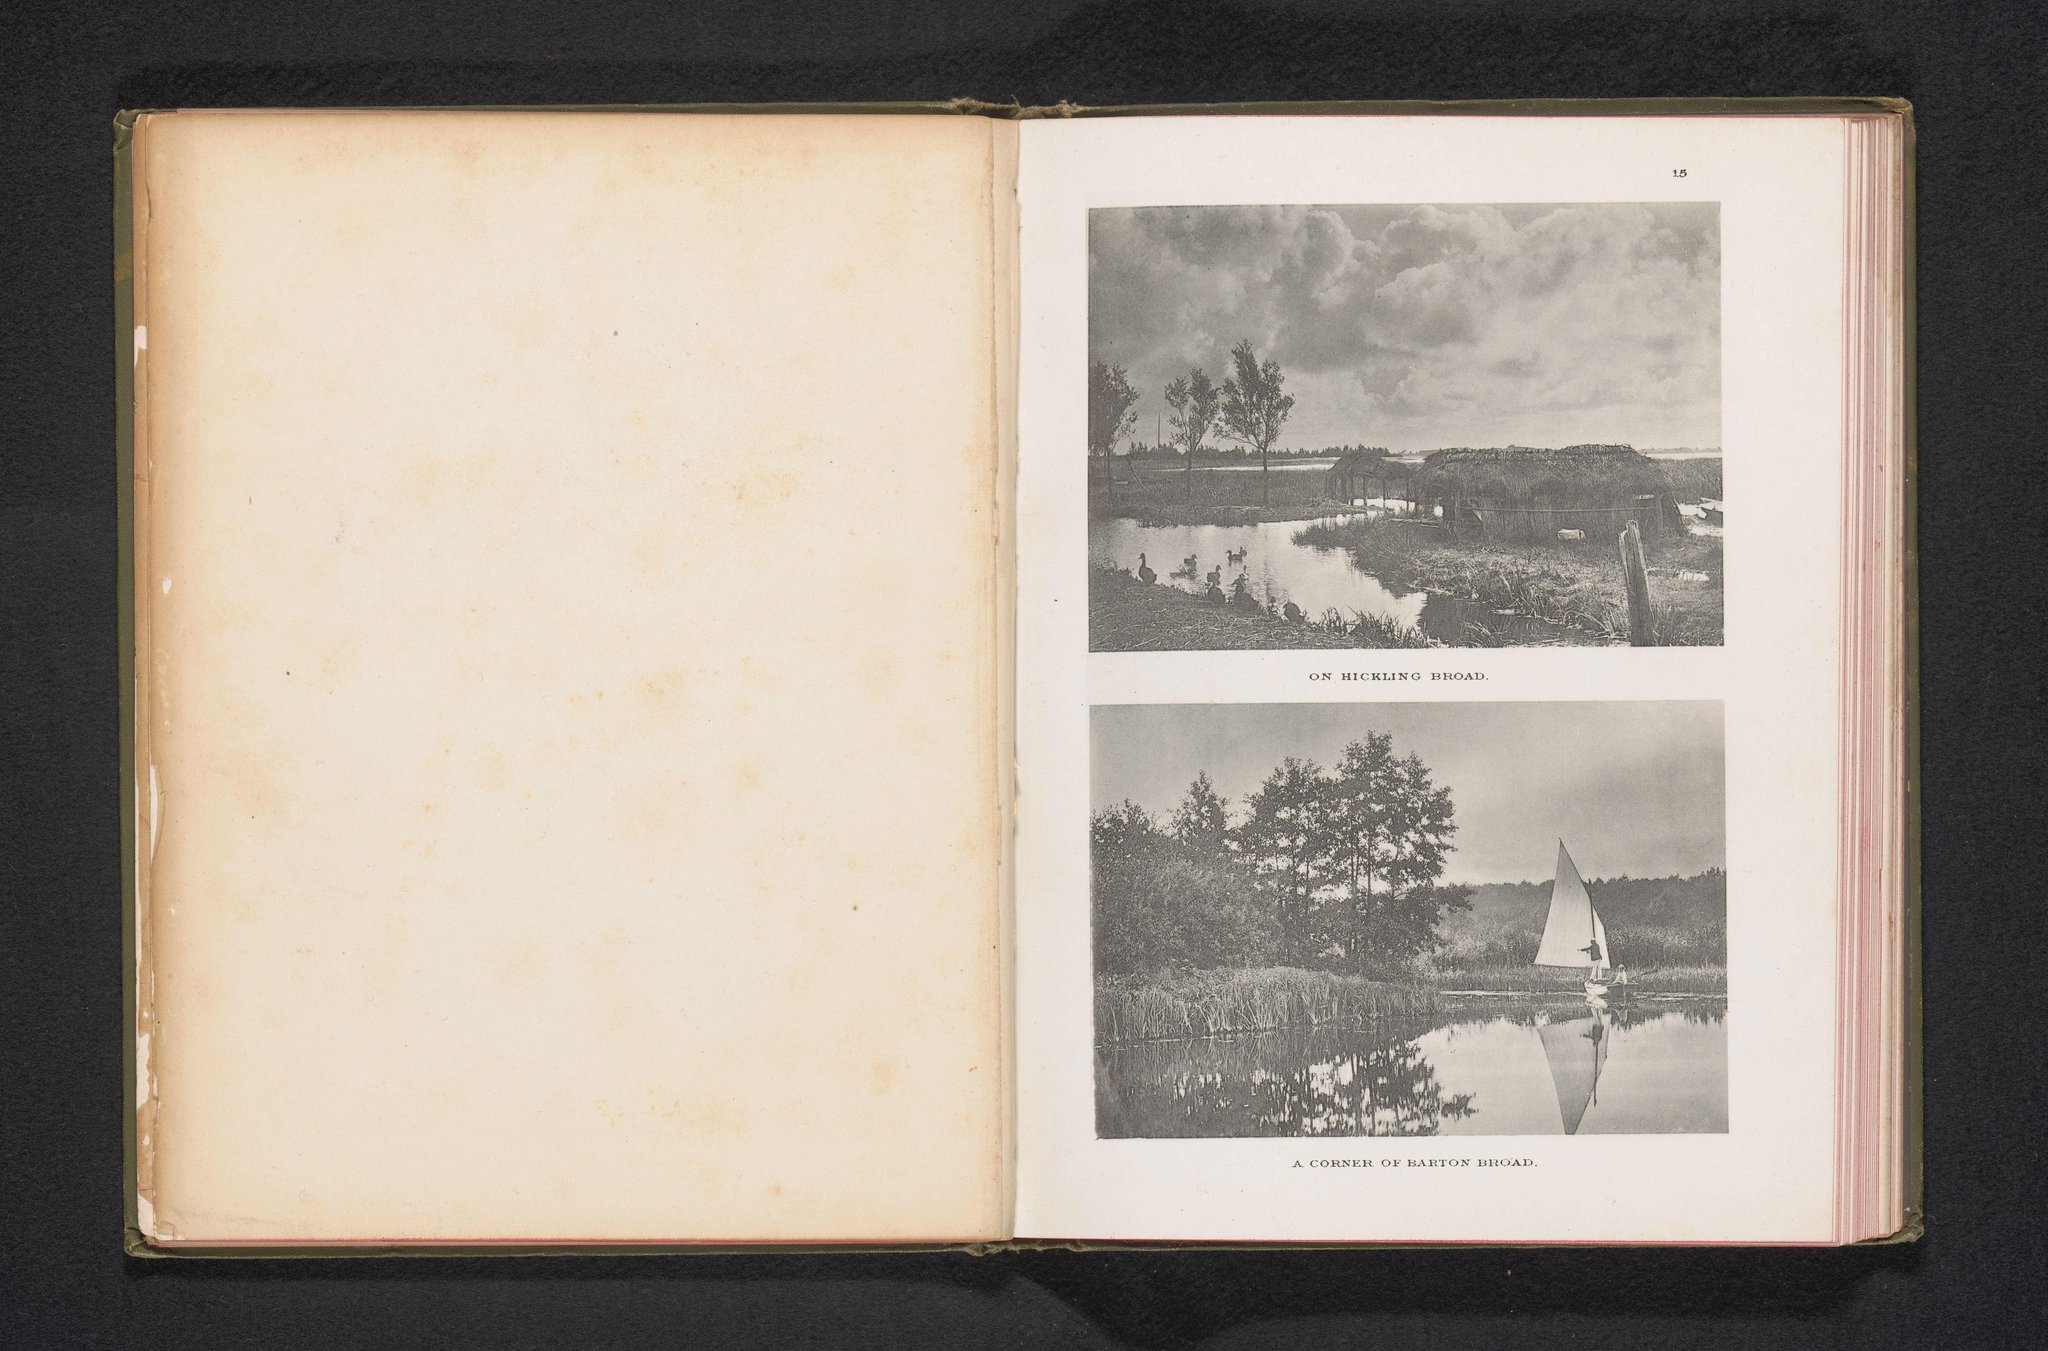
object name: page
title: Gezicht op Hickling Broad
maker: john payne jennings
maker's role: fotograaf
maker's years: 1843-1926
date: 1886-1891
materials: paper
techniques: photograph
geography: surrey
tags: landscapes with waters, waterscapes, seascapes (in the temperate zone), lake